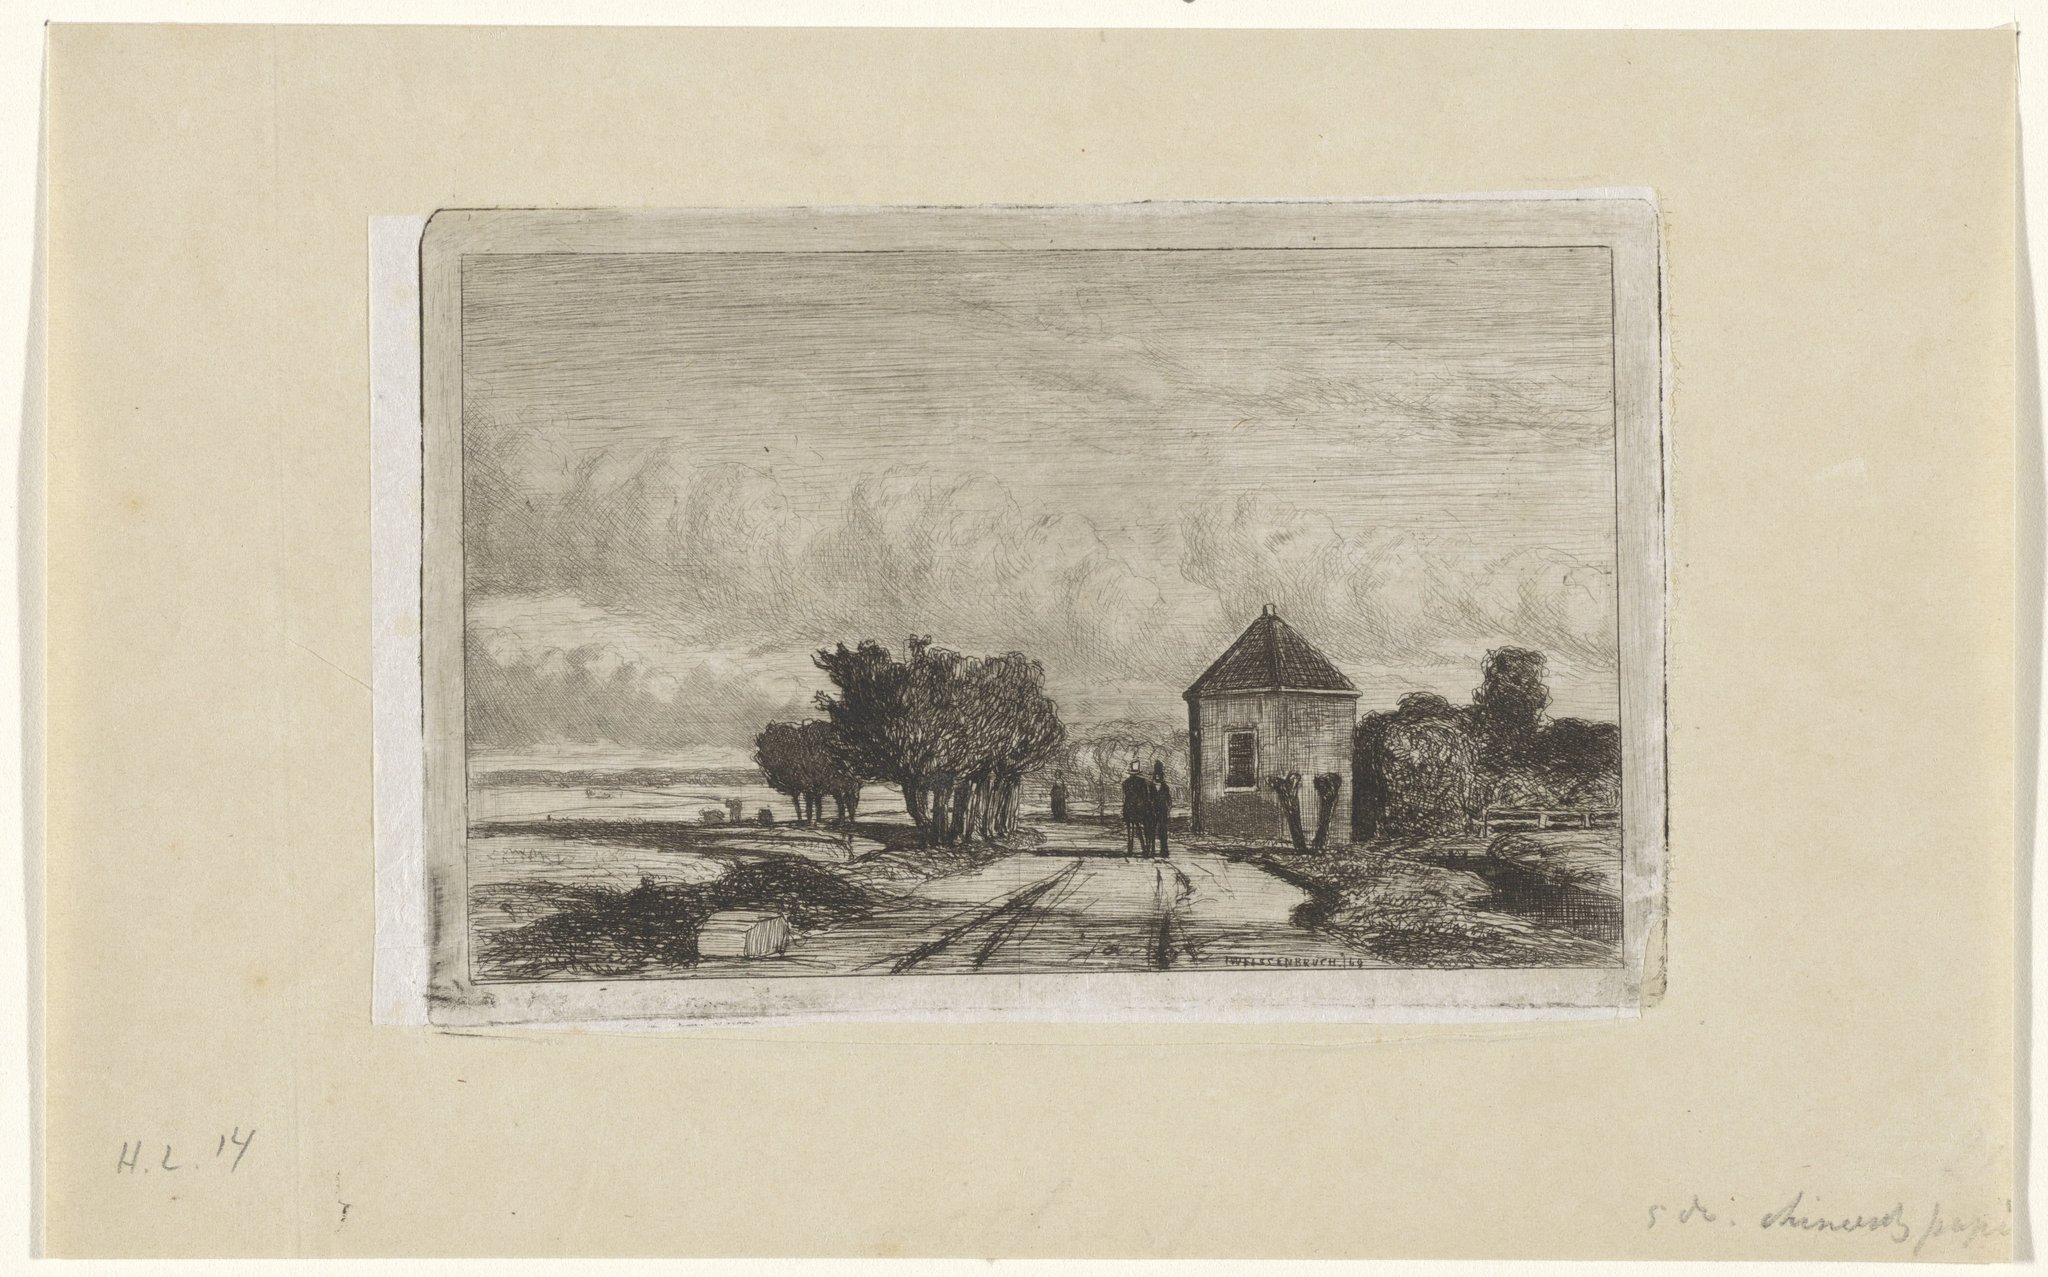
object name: print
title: Gezicht op de Schenkweg met de Koepel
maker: jan weissenbruch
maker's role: painter, print maker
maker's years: 1822-1880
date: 1849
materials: paper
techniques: etching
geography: the hague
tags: trees, landscapes, adult man, road, path, workshop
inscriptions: date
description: Langs de Schenkweg te Den Haag staan enkele bomen. Rechts staat een gebouw dat door de kunstenaar Johannes van der Drift als atelier werd gebruikt. Op de weg staan enkele figuren, onder wie mogelijk leden van de Haagsche Etsclub.